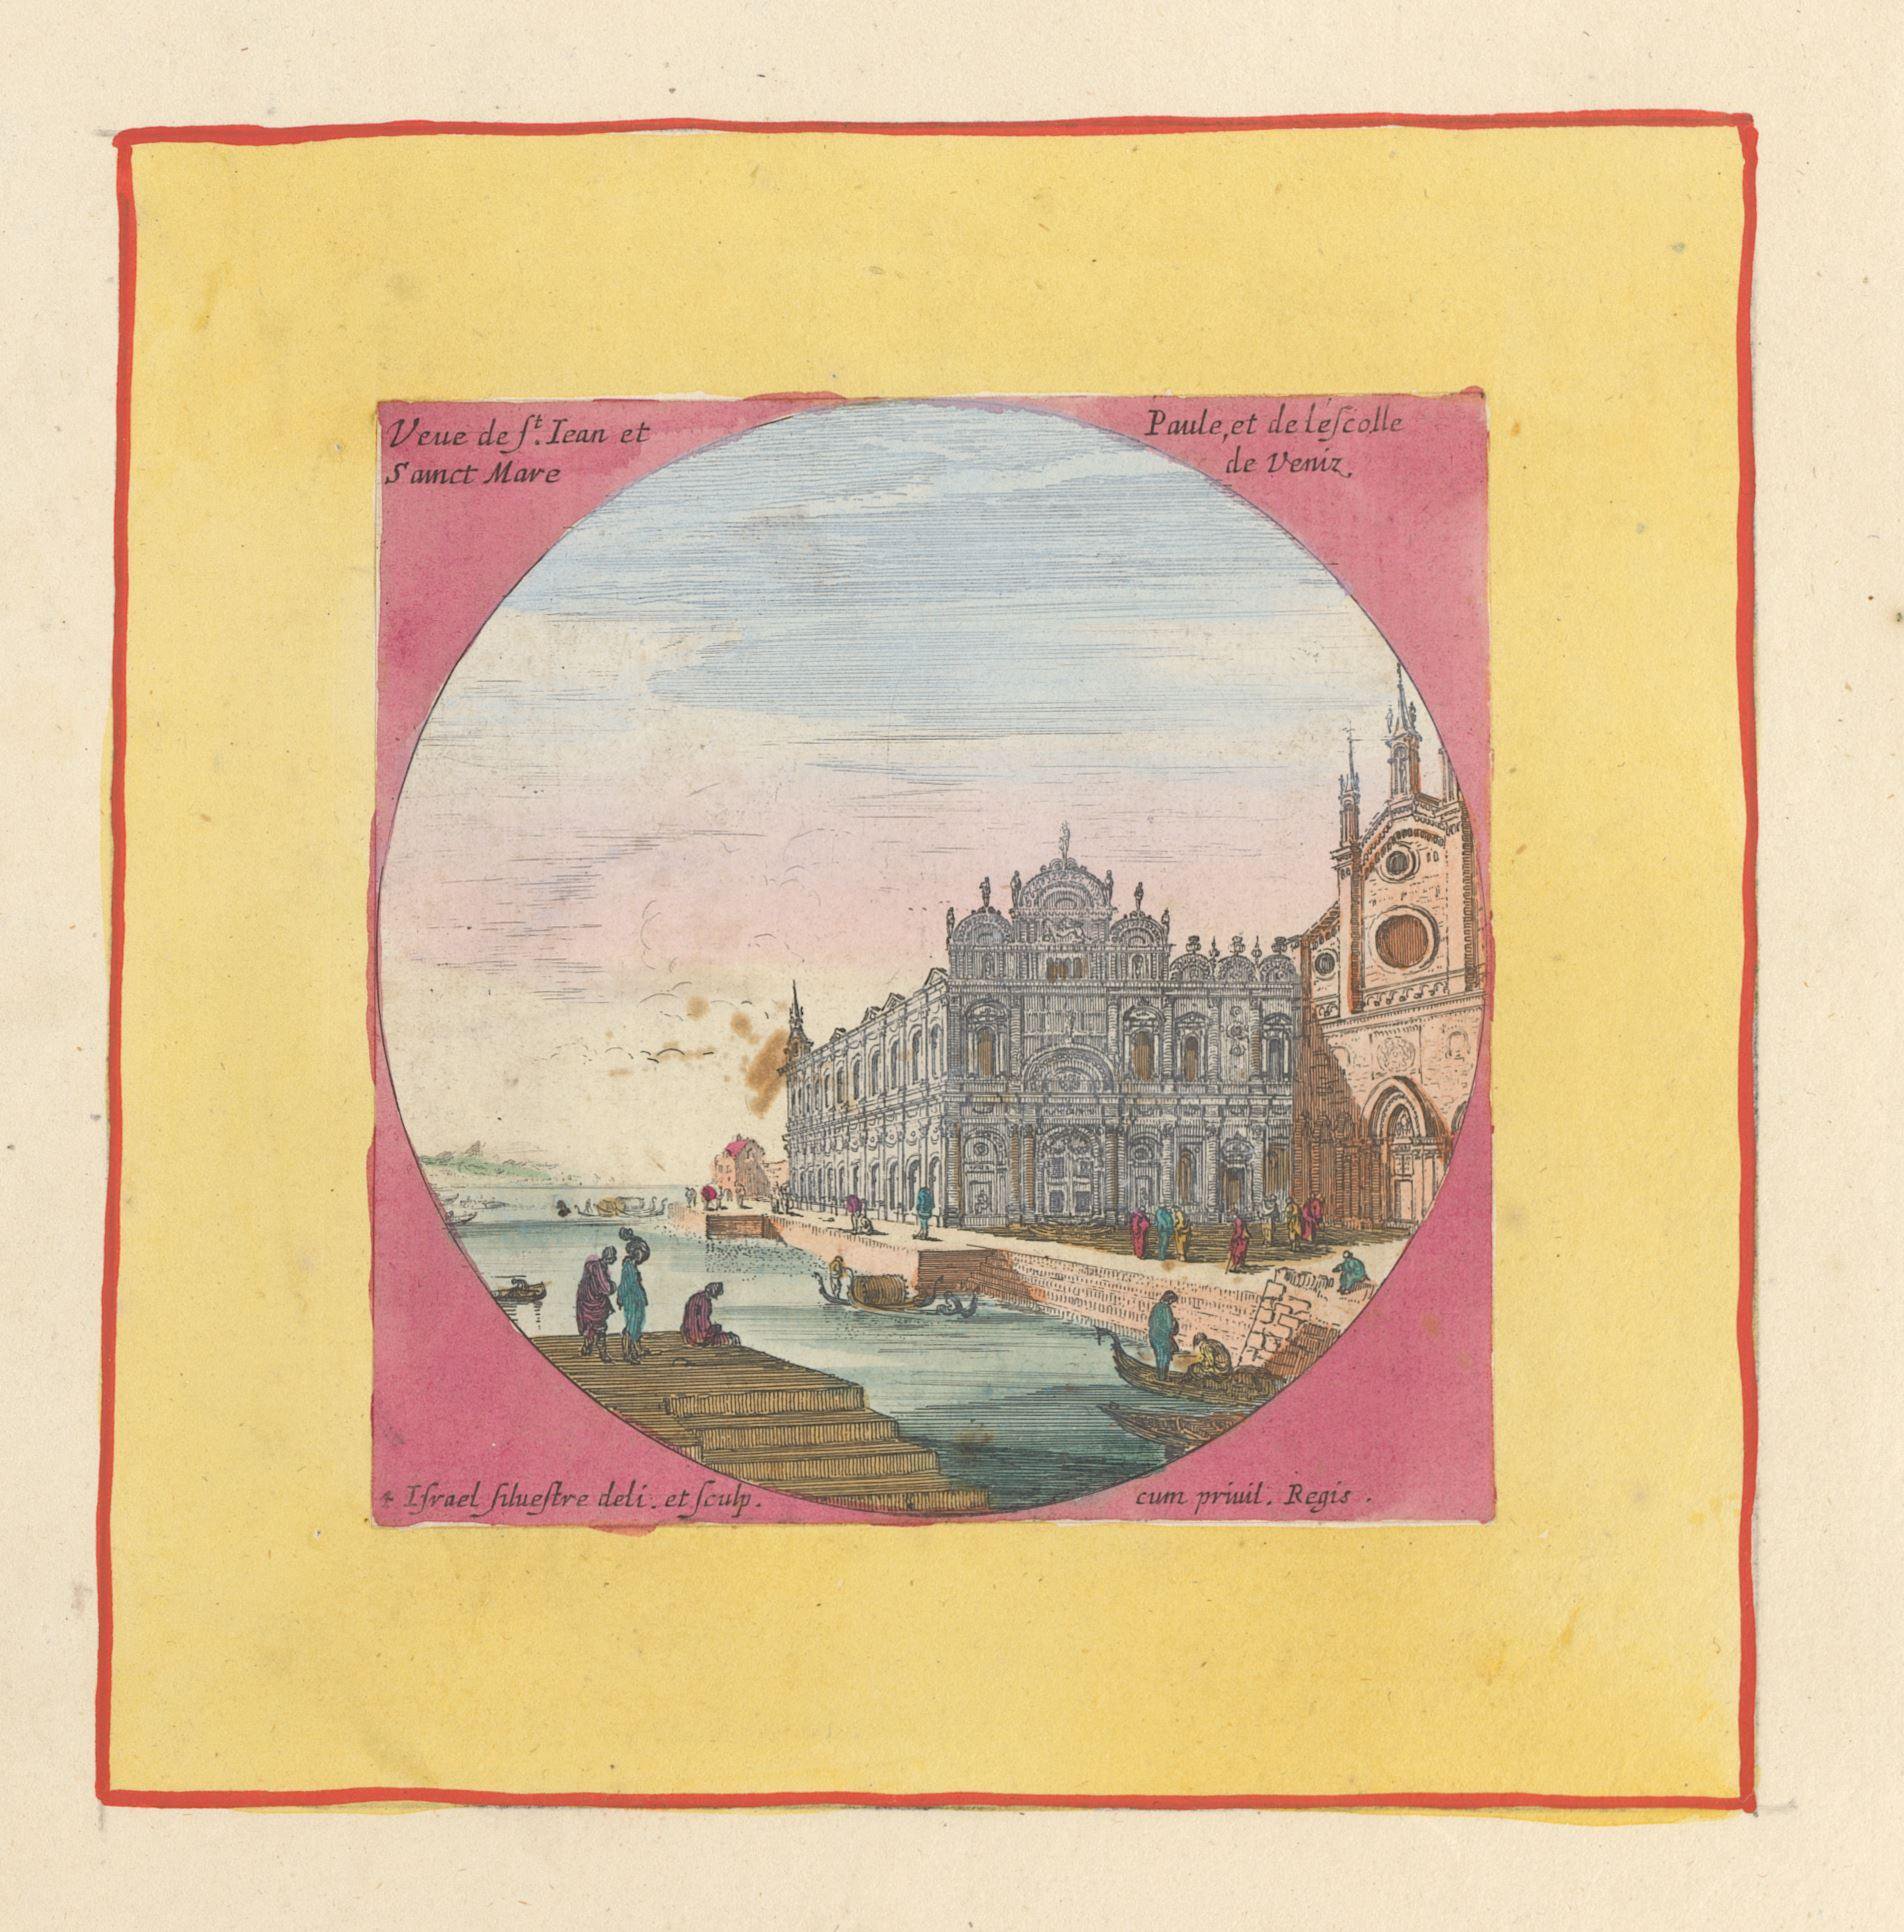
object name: album leaf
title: Diverse zeehavens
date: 1631-1691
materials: paper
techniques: colour, etching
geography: paris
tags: harbour, city-view, and landscape with man-made constructions, church (exterior)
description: Gezicht op de aanmeerplaats voor de Santi Giovanni e Paolo te Venetië. Titel in het Frans boven de voorstelling. Prent maakt deel uit van een album.